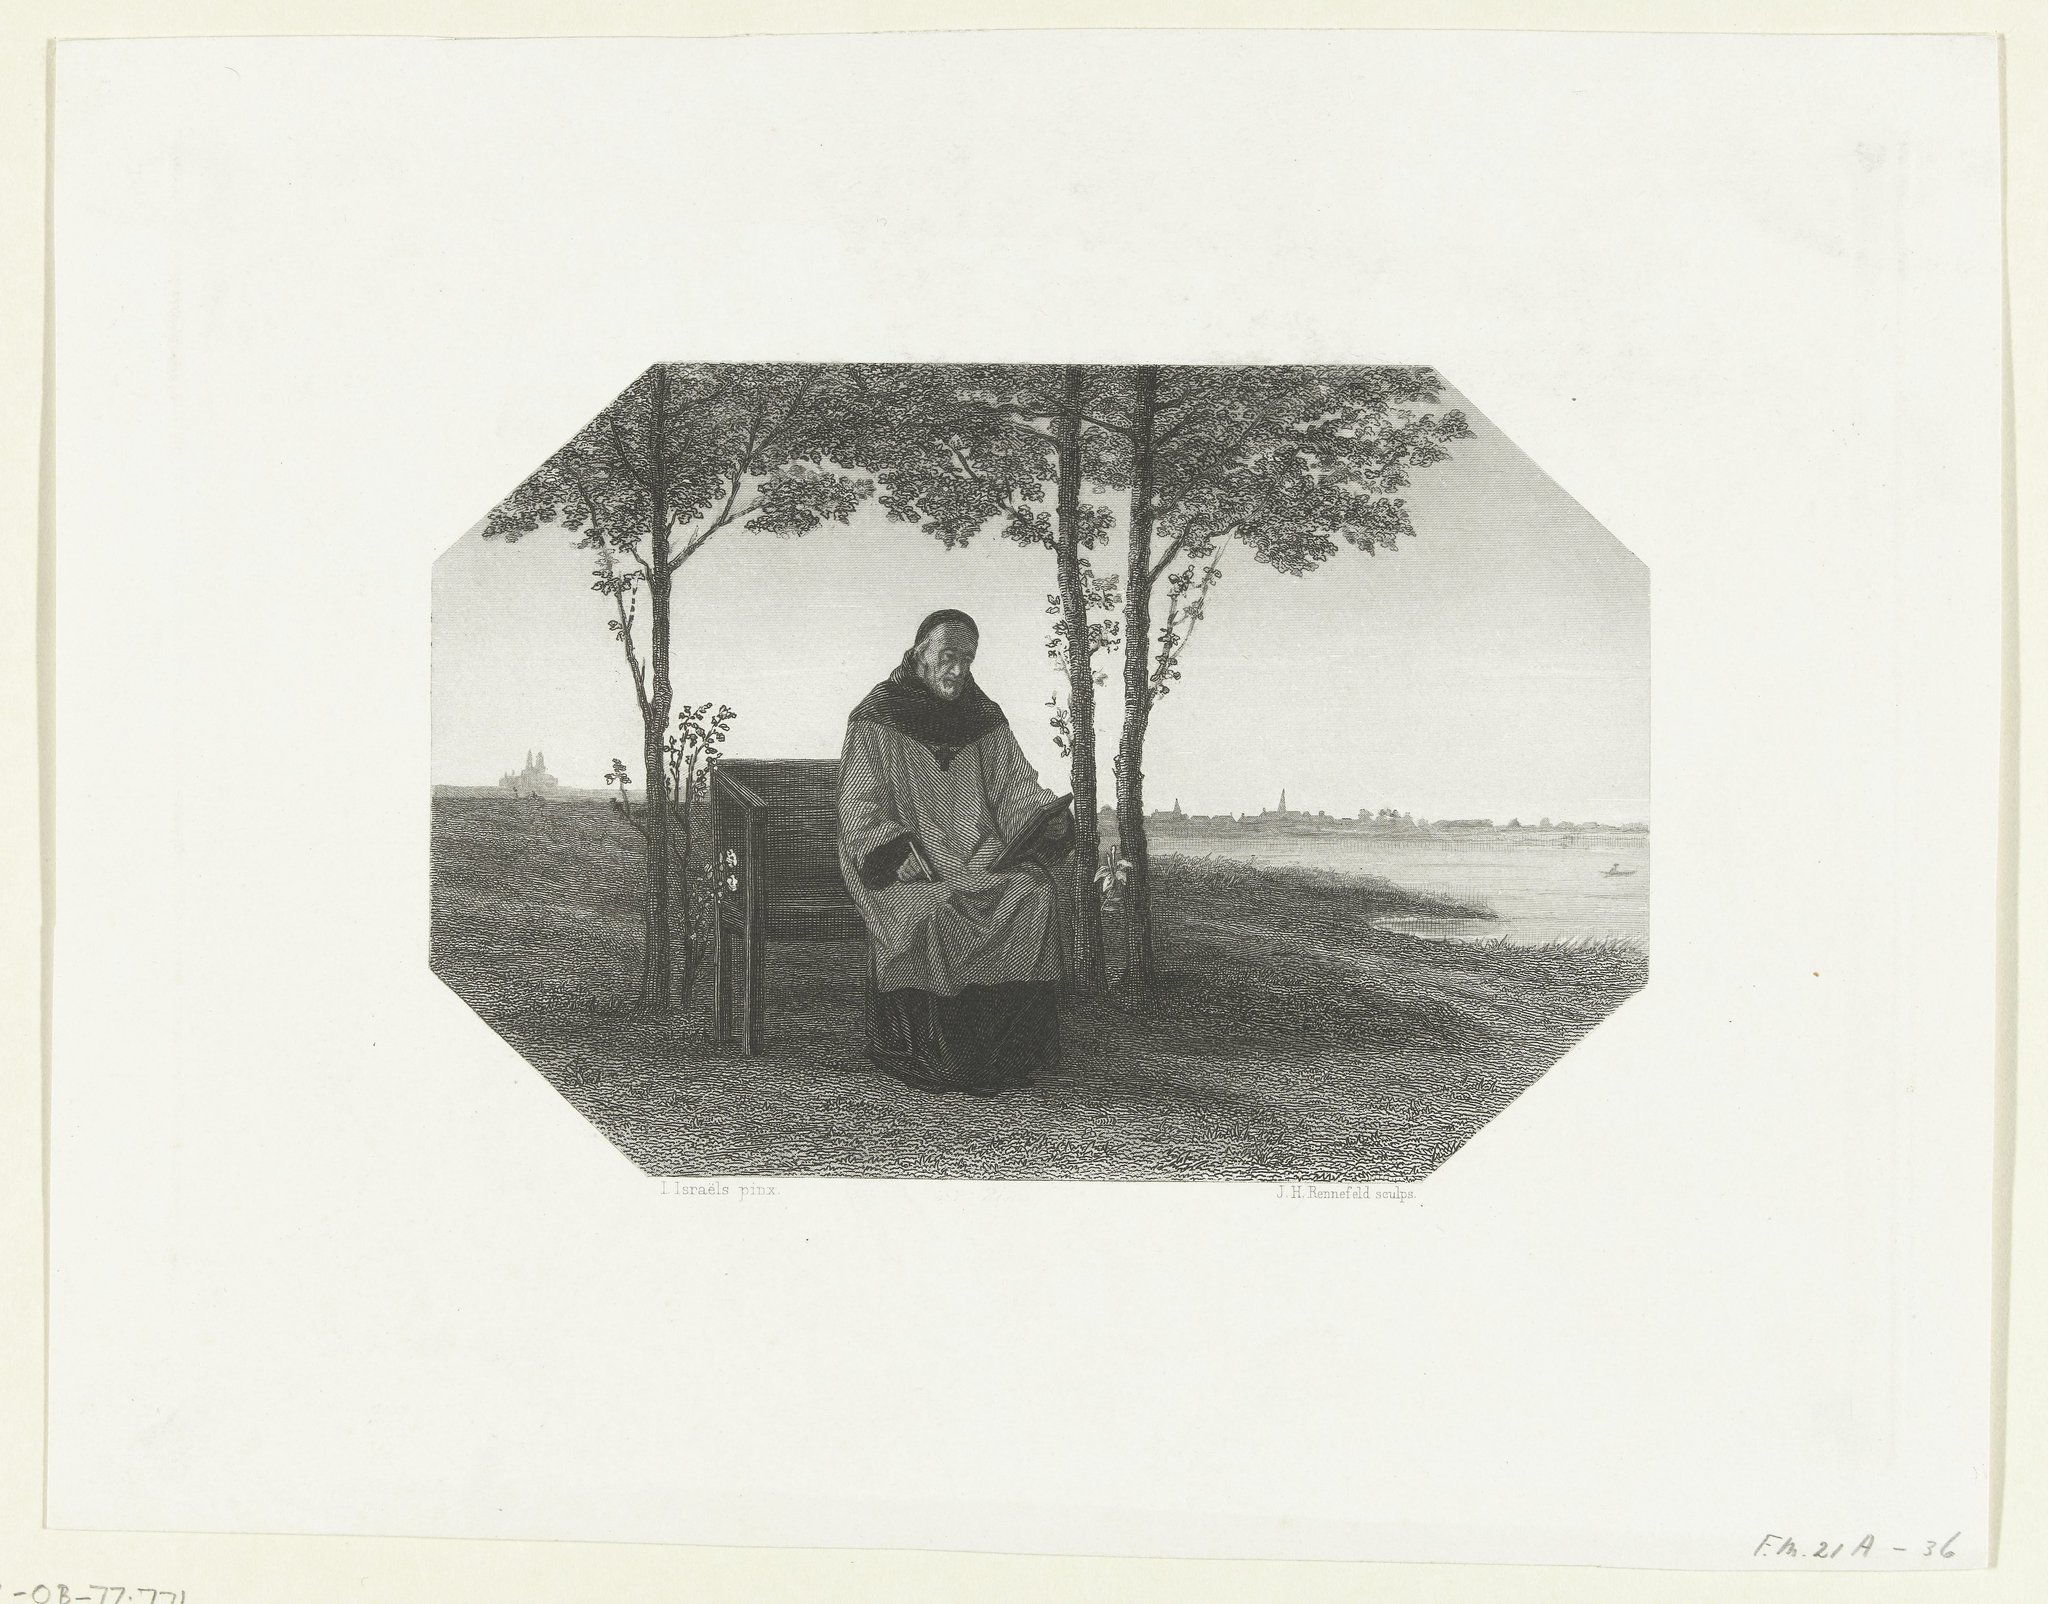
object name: print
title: Thomas à Kempis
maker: johann heinrich maria hubert rennefeld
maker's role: print maker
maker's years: 1832-1877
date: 1865-1870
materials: paper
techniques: engraving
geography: netherlands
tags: priest, thomas à kempis, netherlands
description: Illustratie voor: J. van Lennep en W. Moll en J. ter Gouw, Nederlands geschiedenis en volksleven in schetsen, A.W. Sijthoff, Leiden ca. 1870. Staalgravures naar de schilderijen van de Historische Galerij der Maatschappij Arti en Amicitiae.